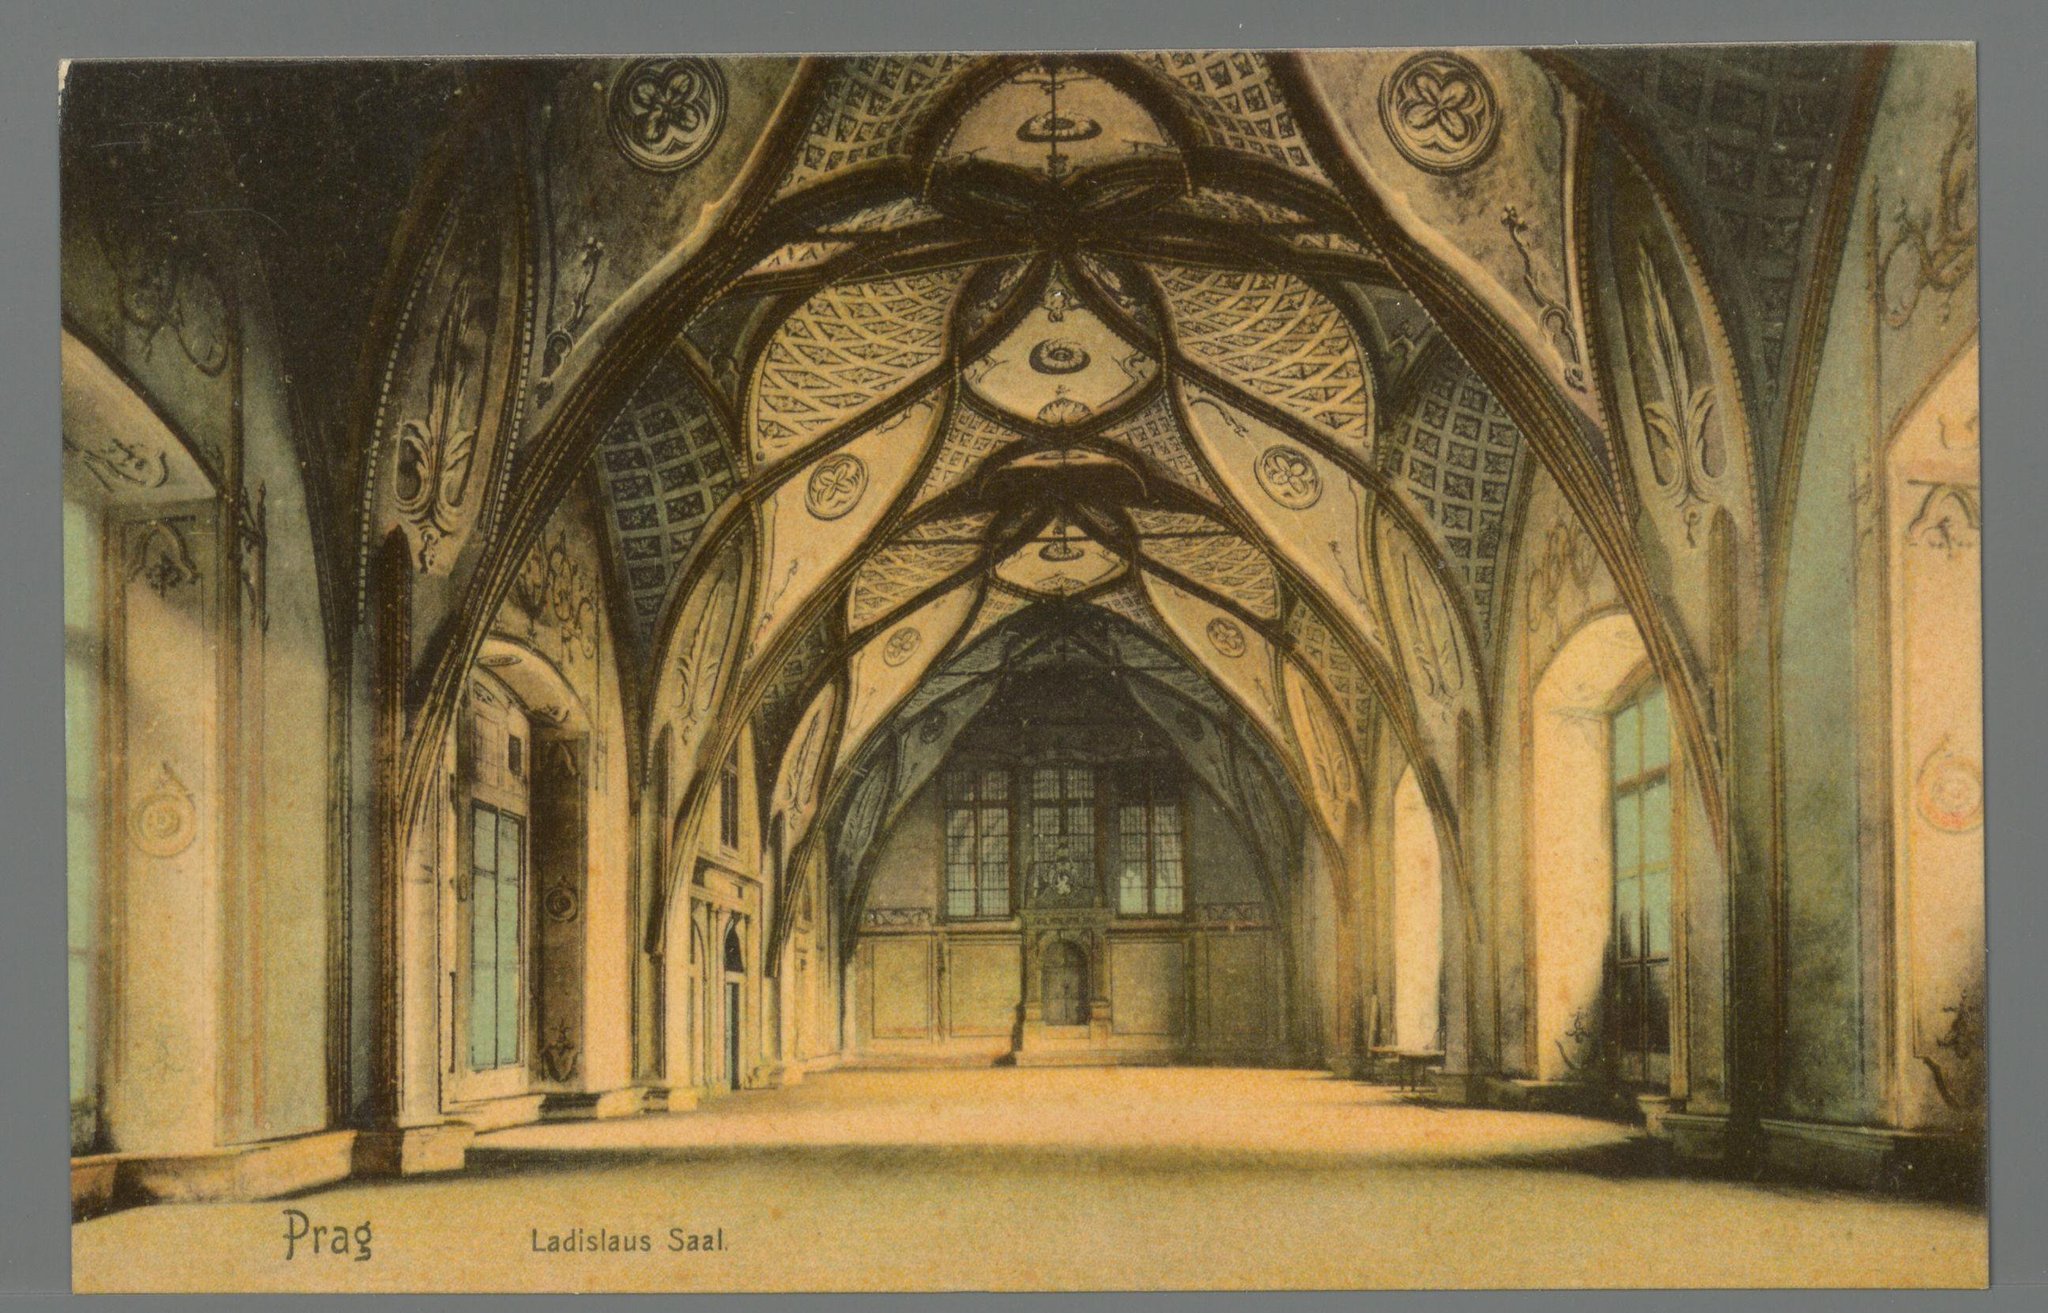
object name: ansichtkaart, prentbriefkaart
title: Prag. Ladislaus Saal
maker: Anonymous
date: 1908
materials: cardboard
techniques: photograph, lithograph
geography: prague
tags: castle, interior of the house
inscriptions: date